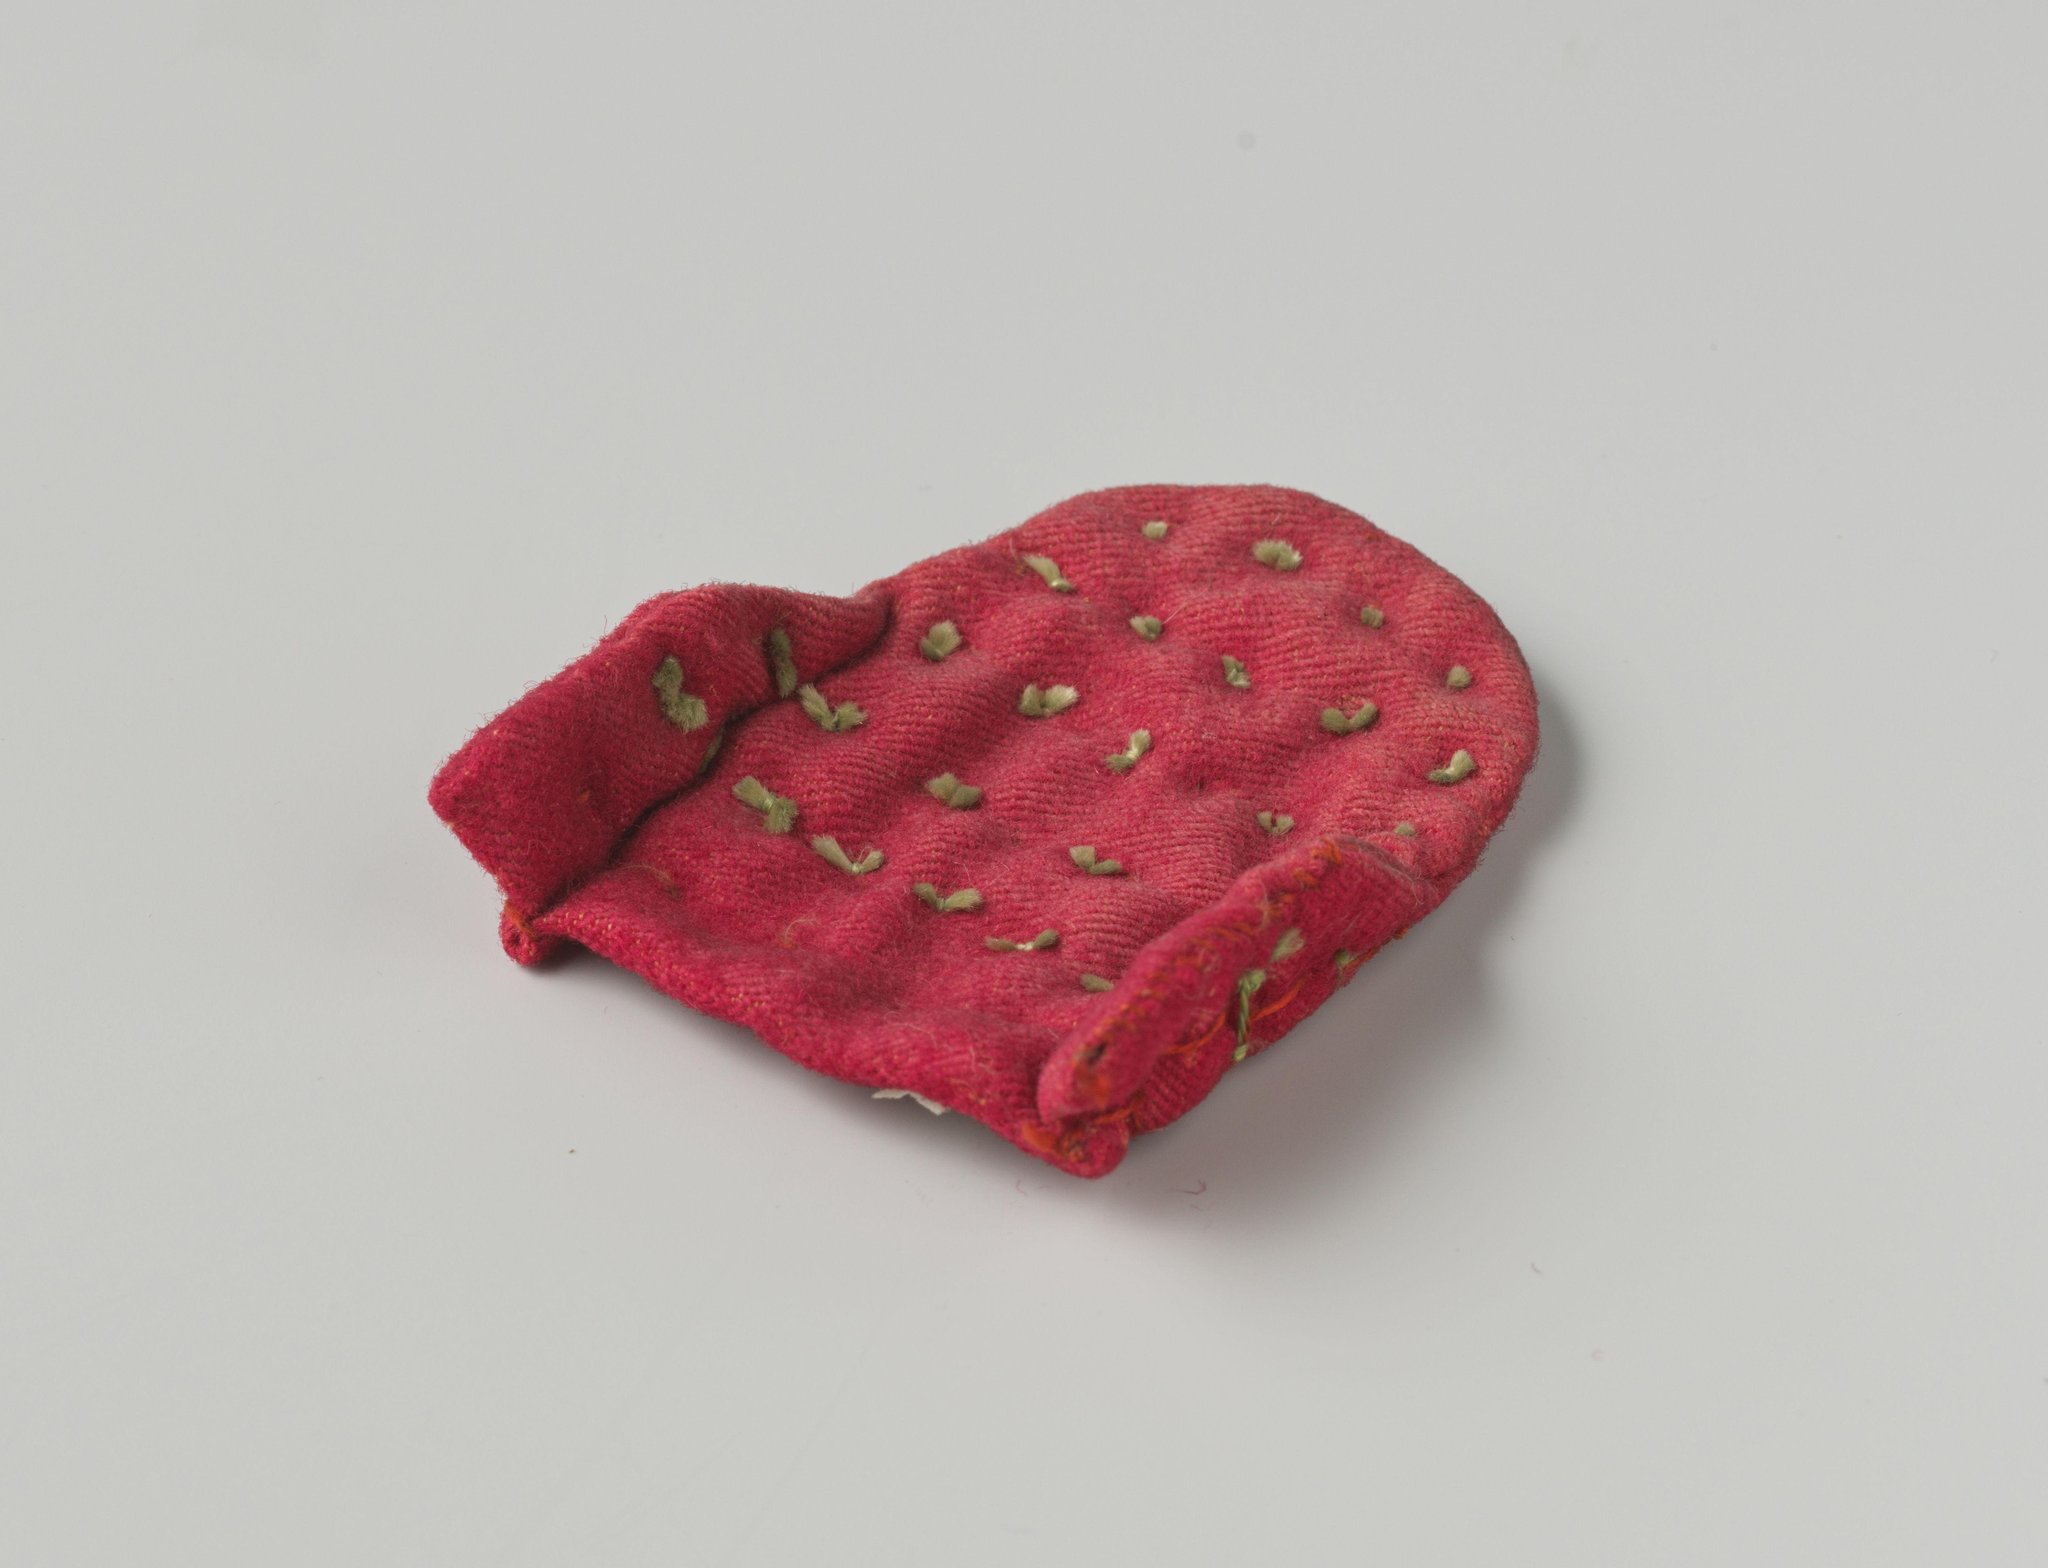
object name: cushion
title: Zitkussen voor poppenhuis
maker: Anonymous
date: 1690-1710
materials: down, silk, wool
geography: amsterdam